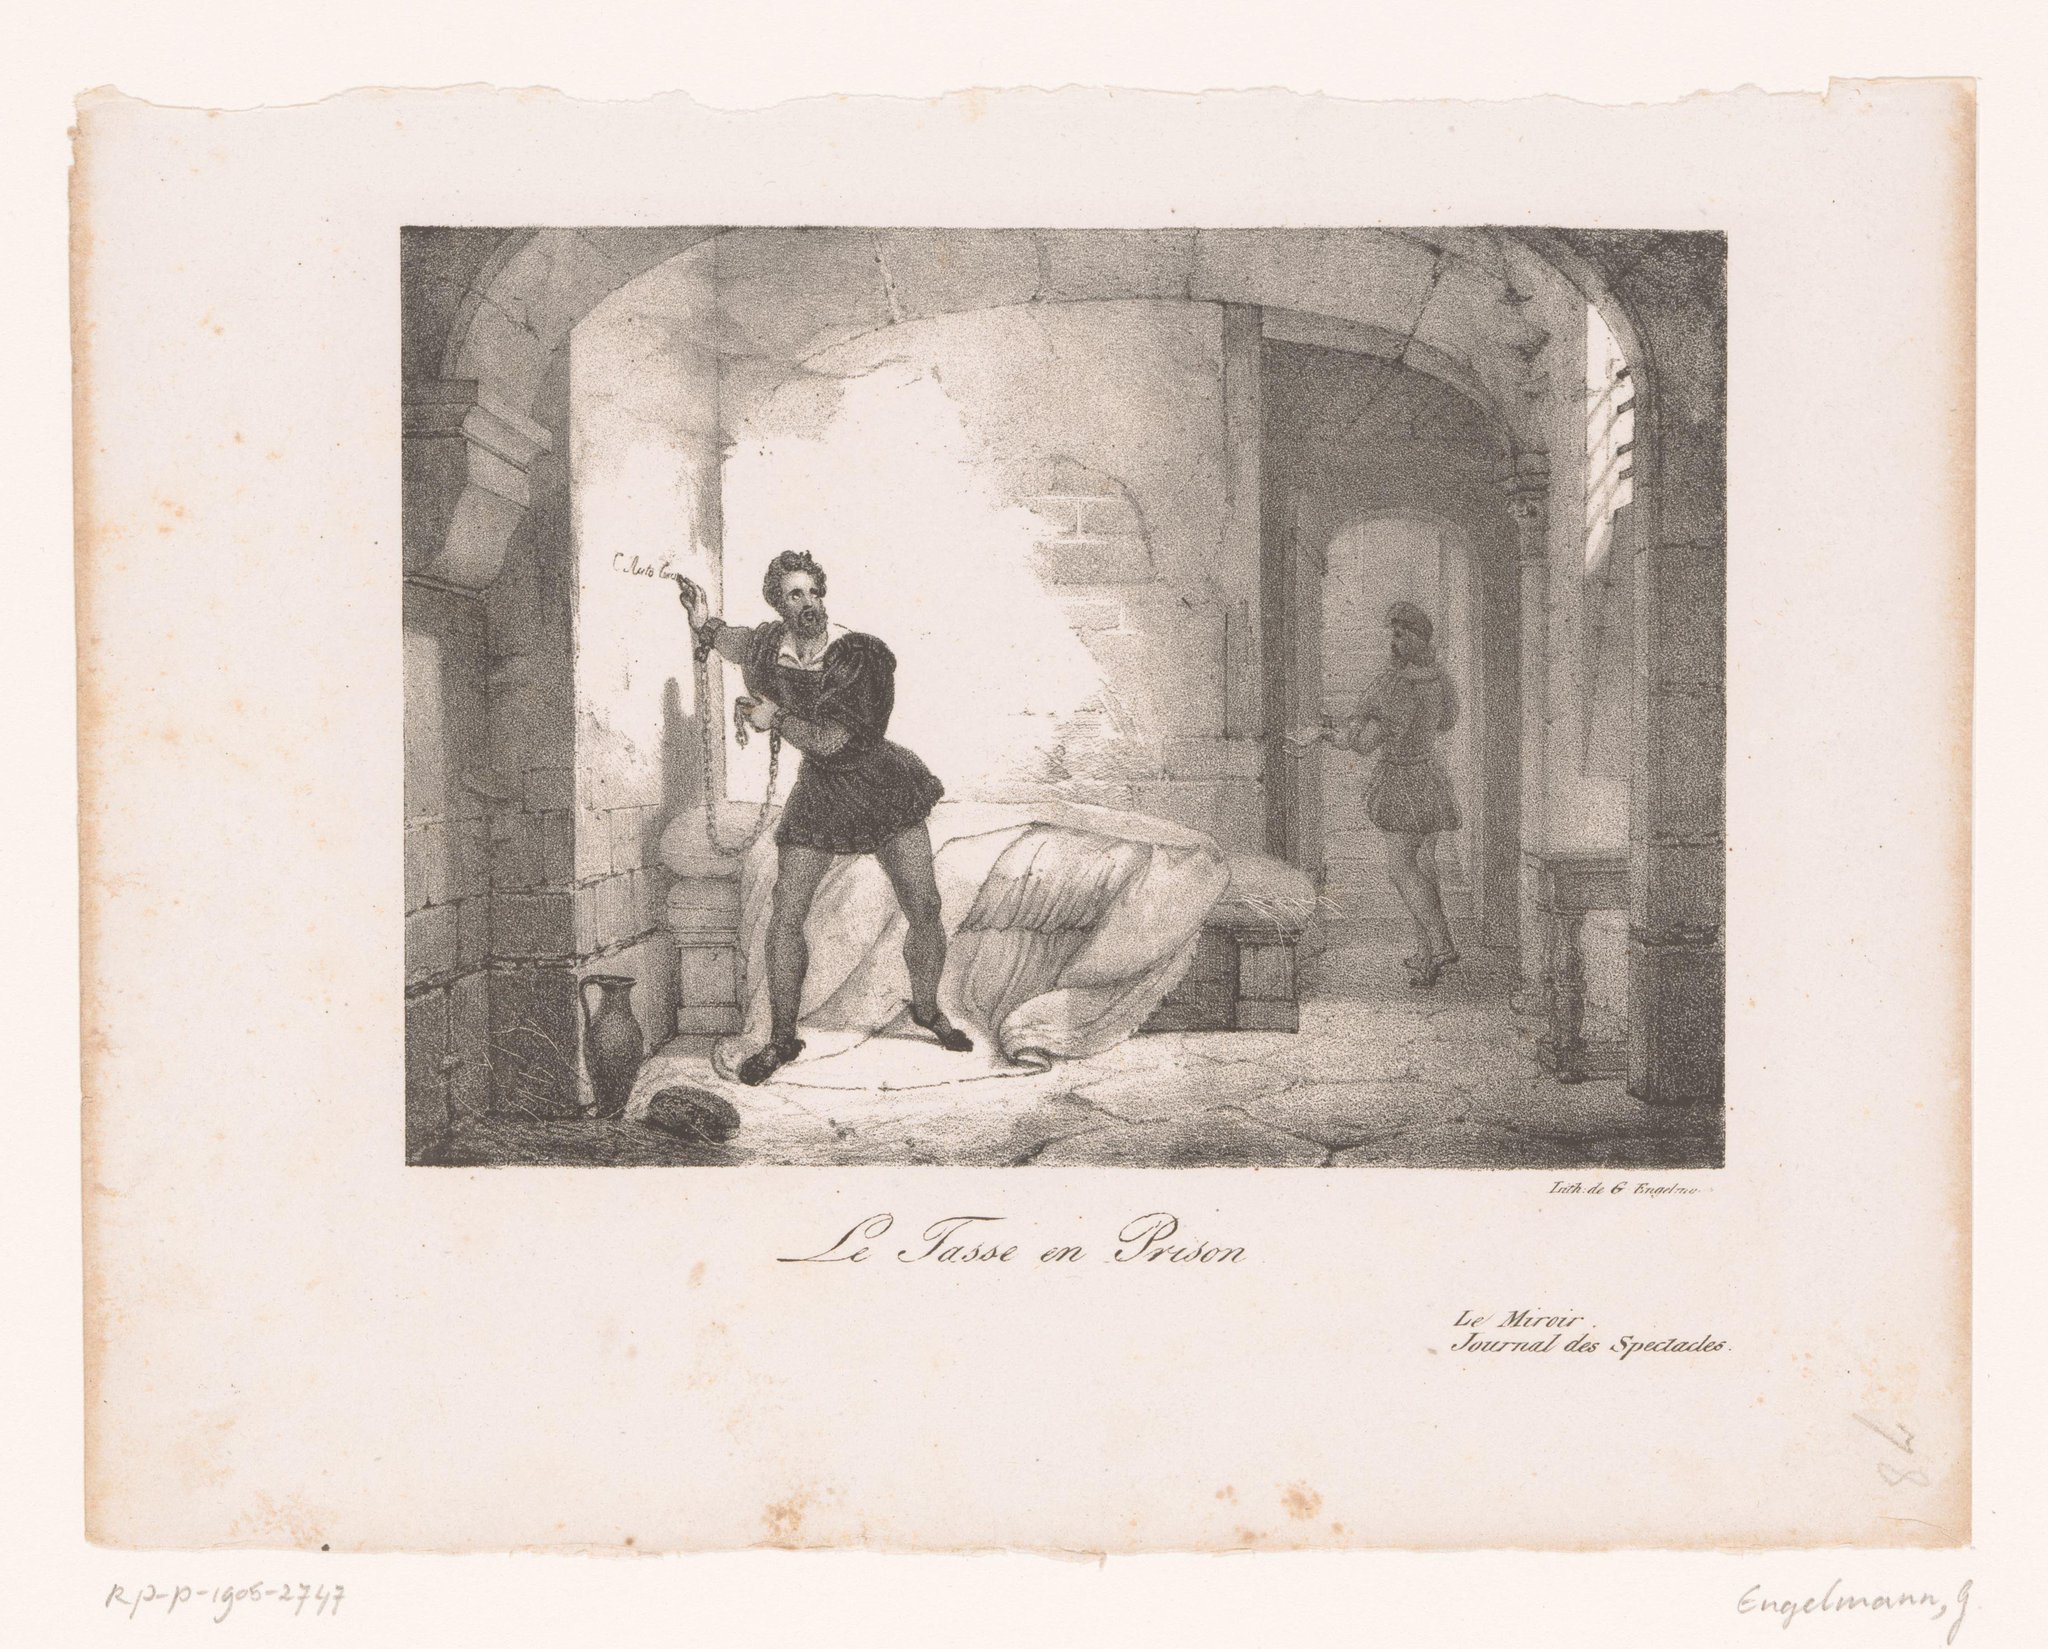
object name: print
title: Le Tasse en Prison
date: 1821-1823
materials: paper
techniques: lithograph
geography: paris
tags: torquato tasso, historical persons, prisoner in cell or locked place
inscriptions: collector's mark: Lugt 2228a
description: Prent gebruikt in: Le Miroir des spectacles, des lettres, des mœurs et des arts, 1821-1823.